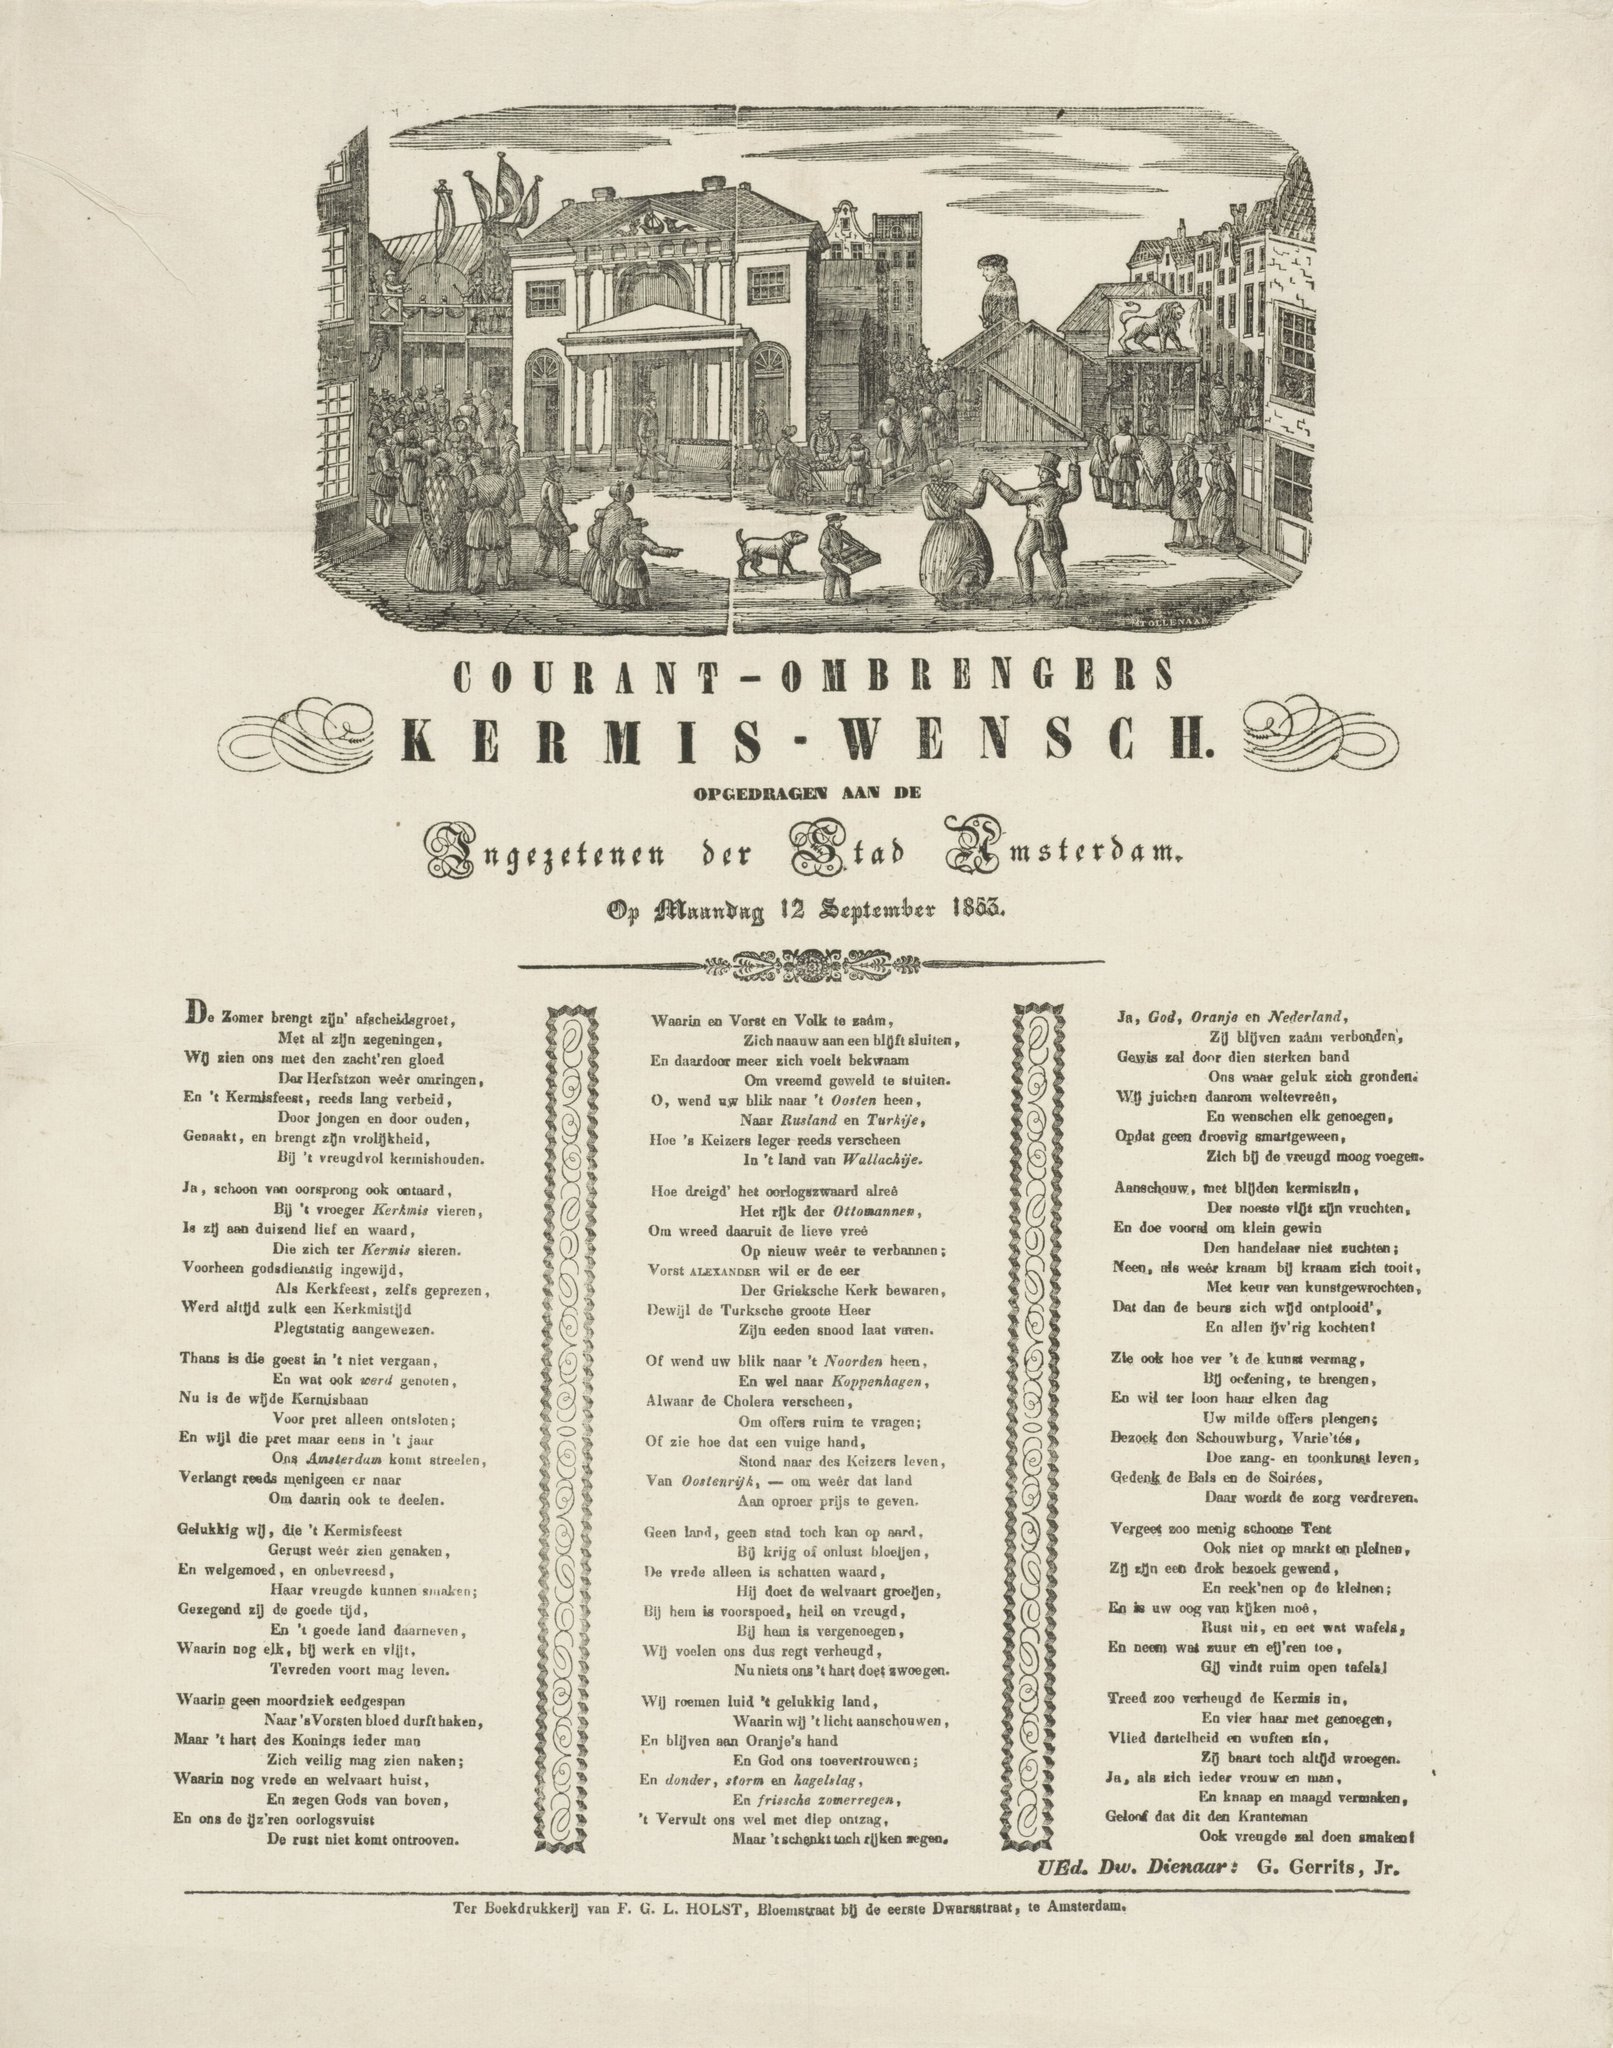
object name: print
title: Kermisprent van de Amsterdamse courantombrengers voor het jaar 1853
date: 1853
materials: paper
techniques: letterpress printing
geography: amsterdam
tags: pleasure fair and circus, amsterdam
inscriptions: collector's mark: Lugt 2228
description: Kermisprent namens de ombrengers van couranten (krantenbezorgers) te Amsterdam, 12 september 1853. Bovenaan de kermis op de Botermarkt met de Boterhal en het standbeeld van Rembrandt (onthuld mei 1852). Onderaan een gedicht in drie kolommen. Van de courantombrenger: G. Gerrits Jr.